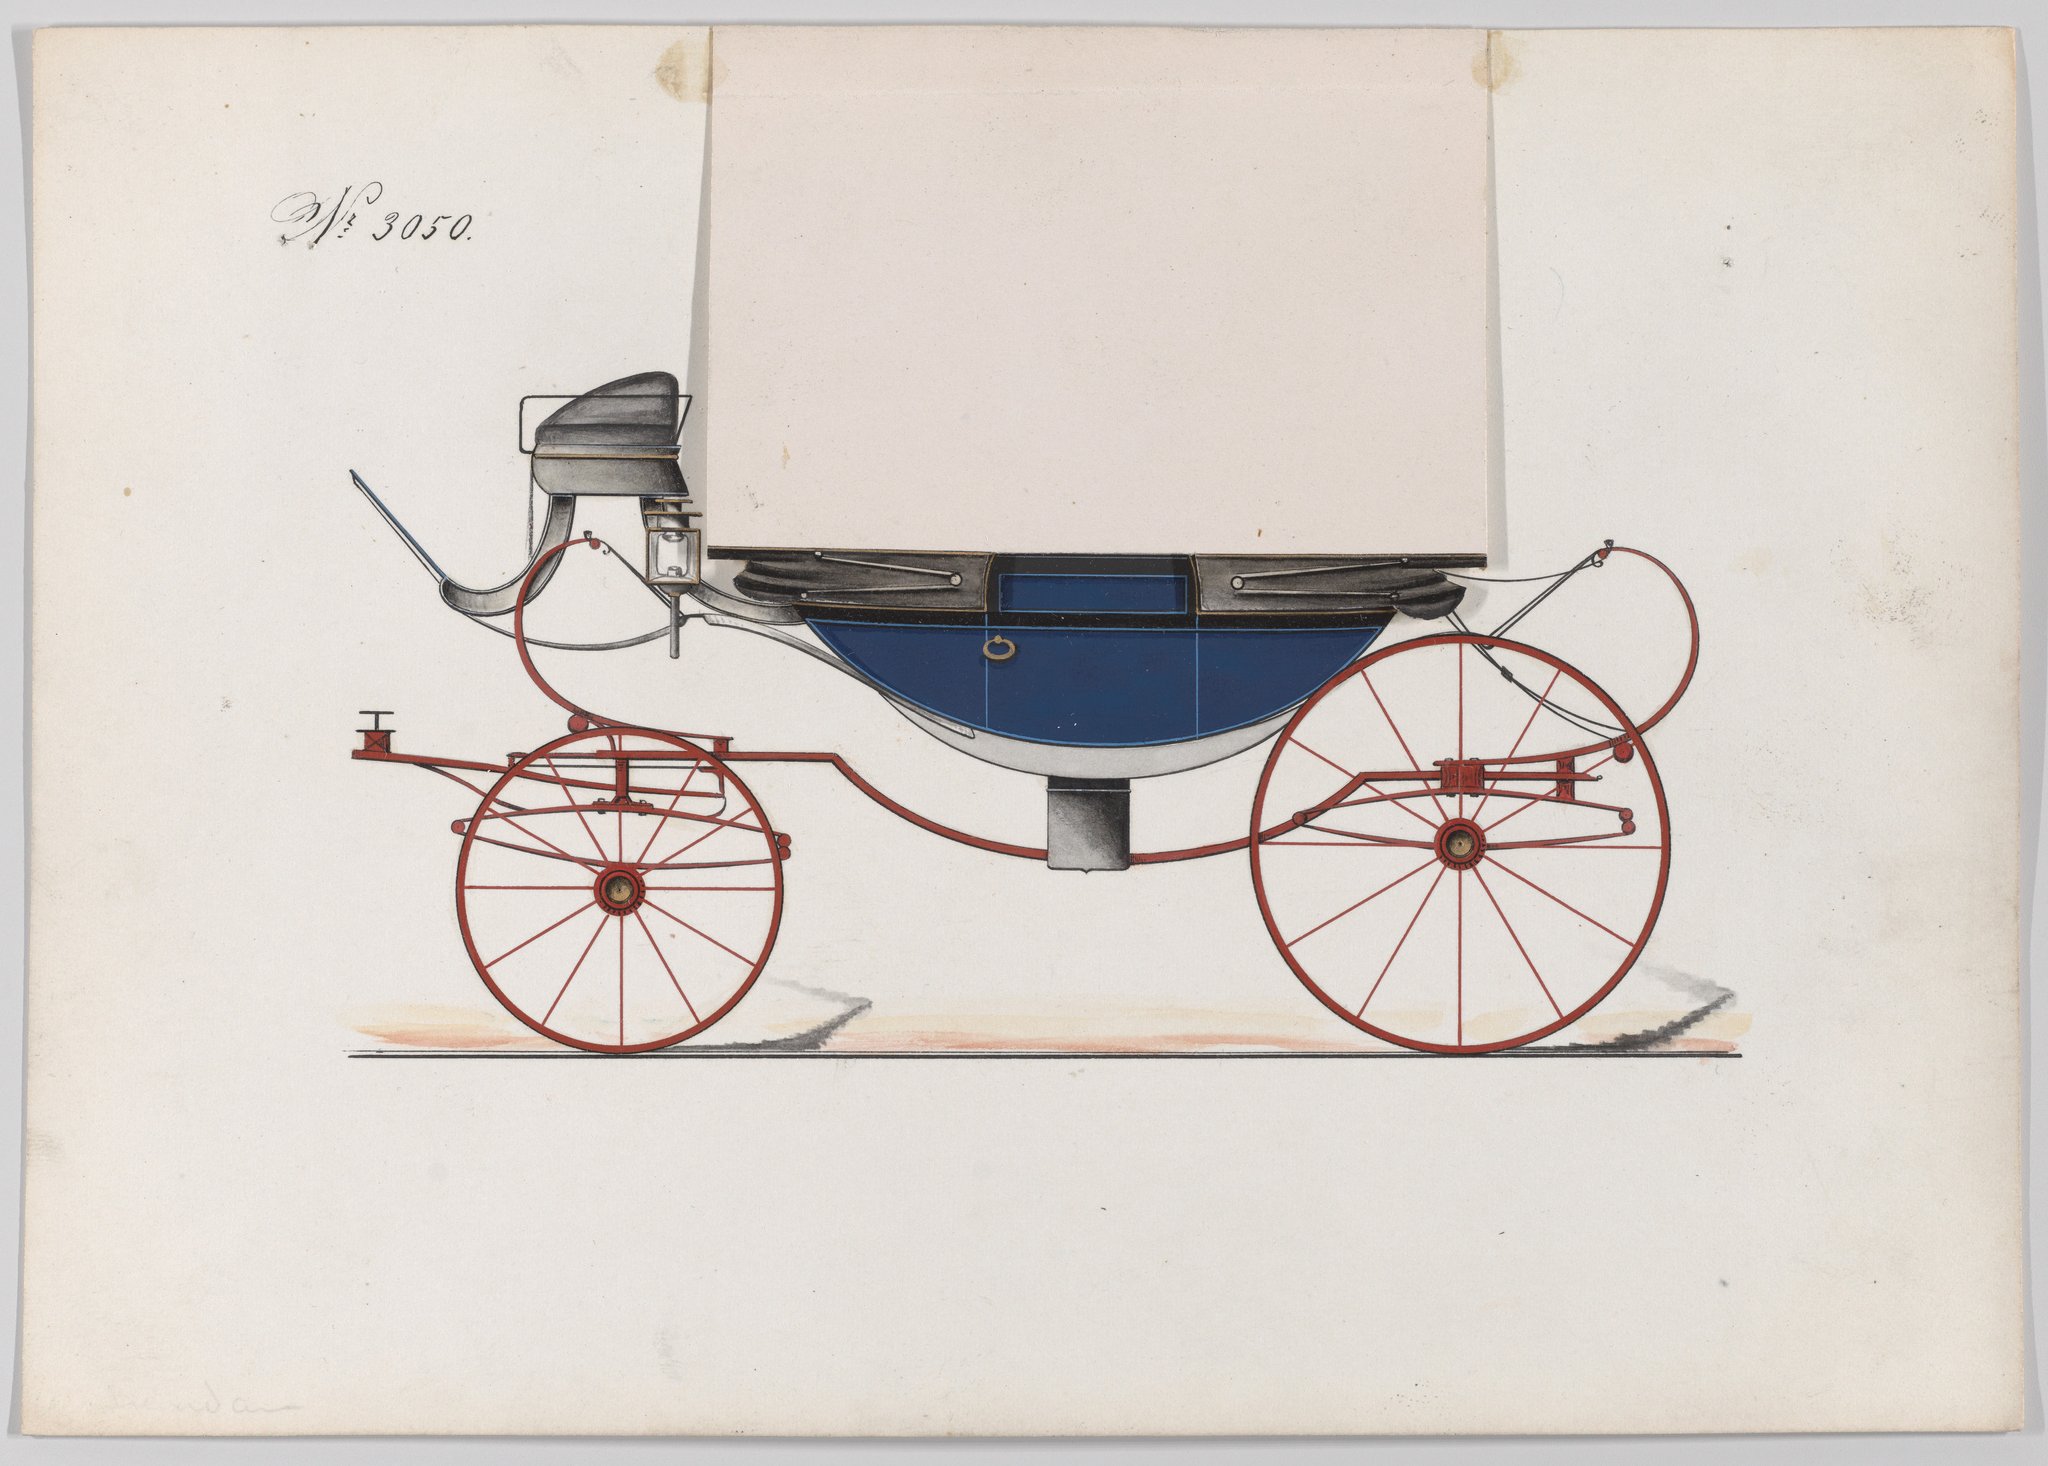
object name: drawing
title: Design for Landau, No. 3050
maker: brewster & co.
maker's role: manufacturer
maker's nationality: american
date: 1874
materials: gouache, gum arabic, ink, watercolor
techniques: pen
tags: carriages